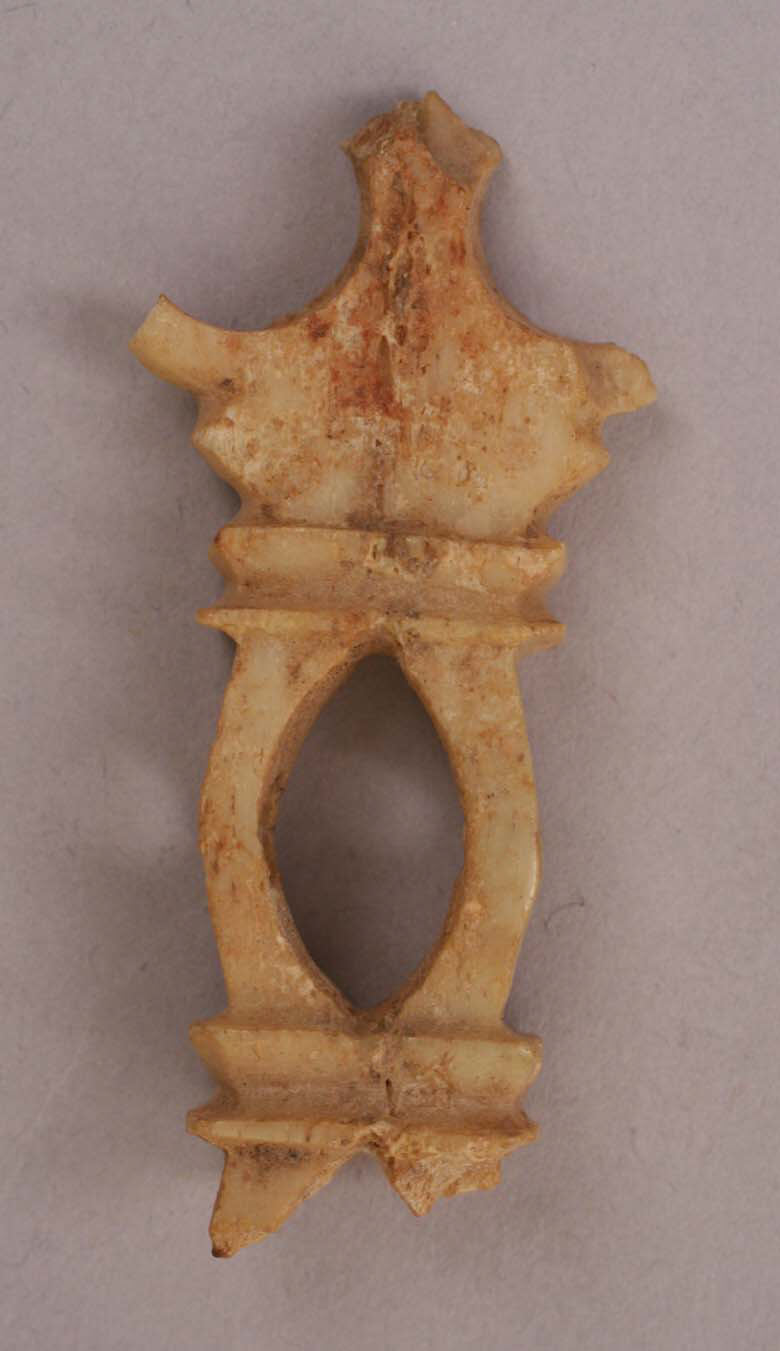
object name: handle or ornament or tool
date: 801-1000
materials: bone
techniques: carving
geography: iran